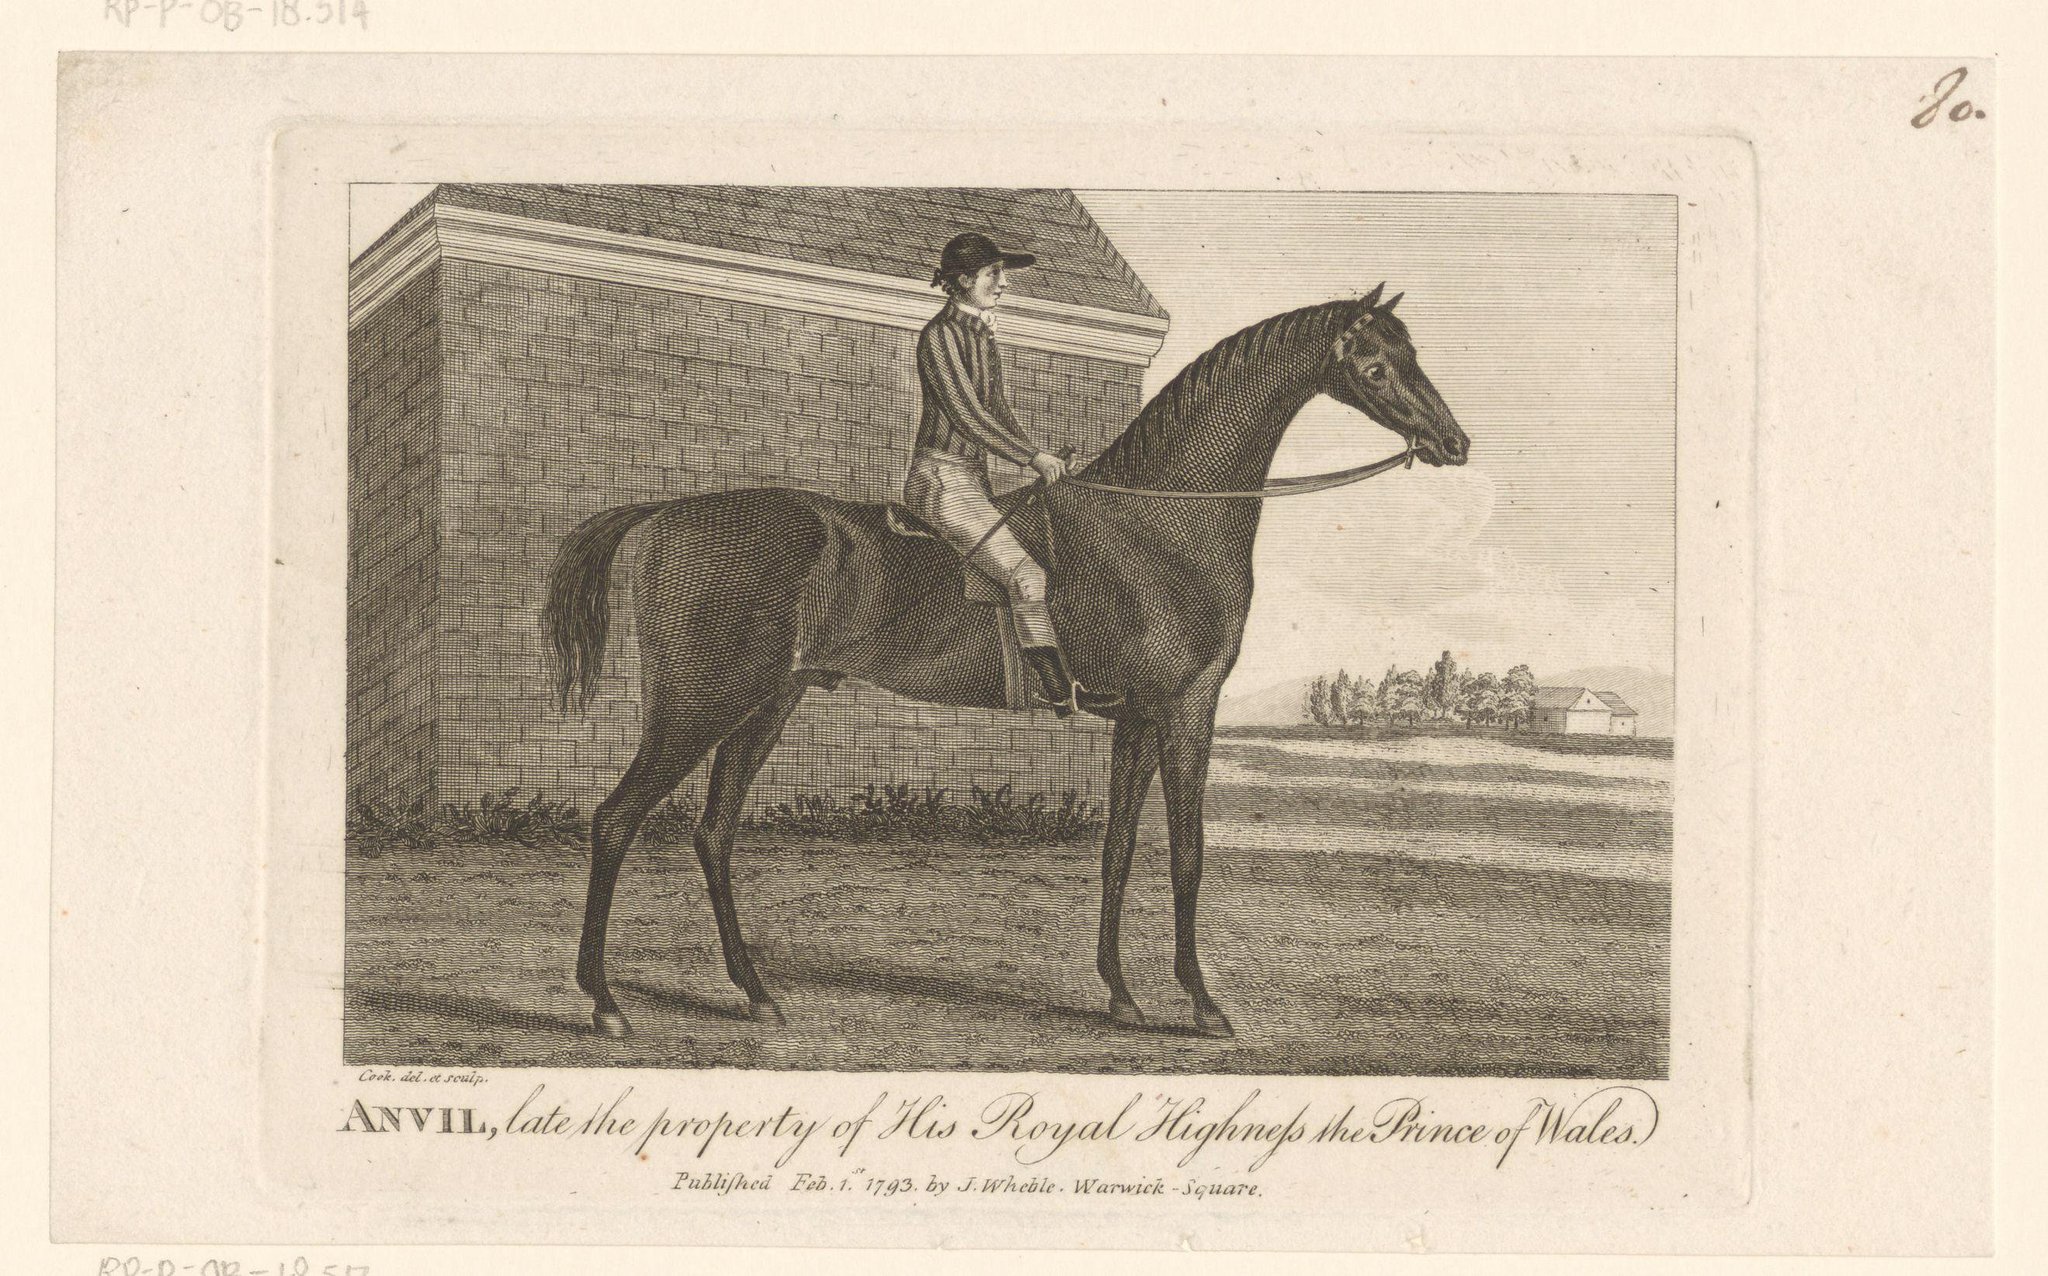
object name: print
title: Paard met ruiter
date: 1793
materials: paper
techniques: etching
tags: horses and kindred animals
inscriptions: collector's mark: Lugt 2228, number: ‘80’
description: Prent gebruikt in: Sporting Magazine 1 (1793).